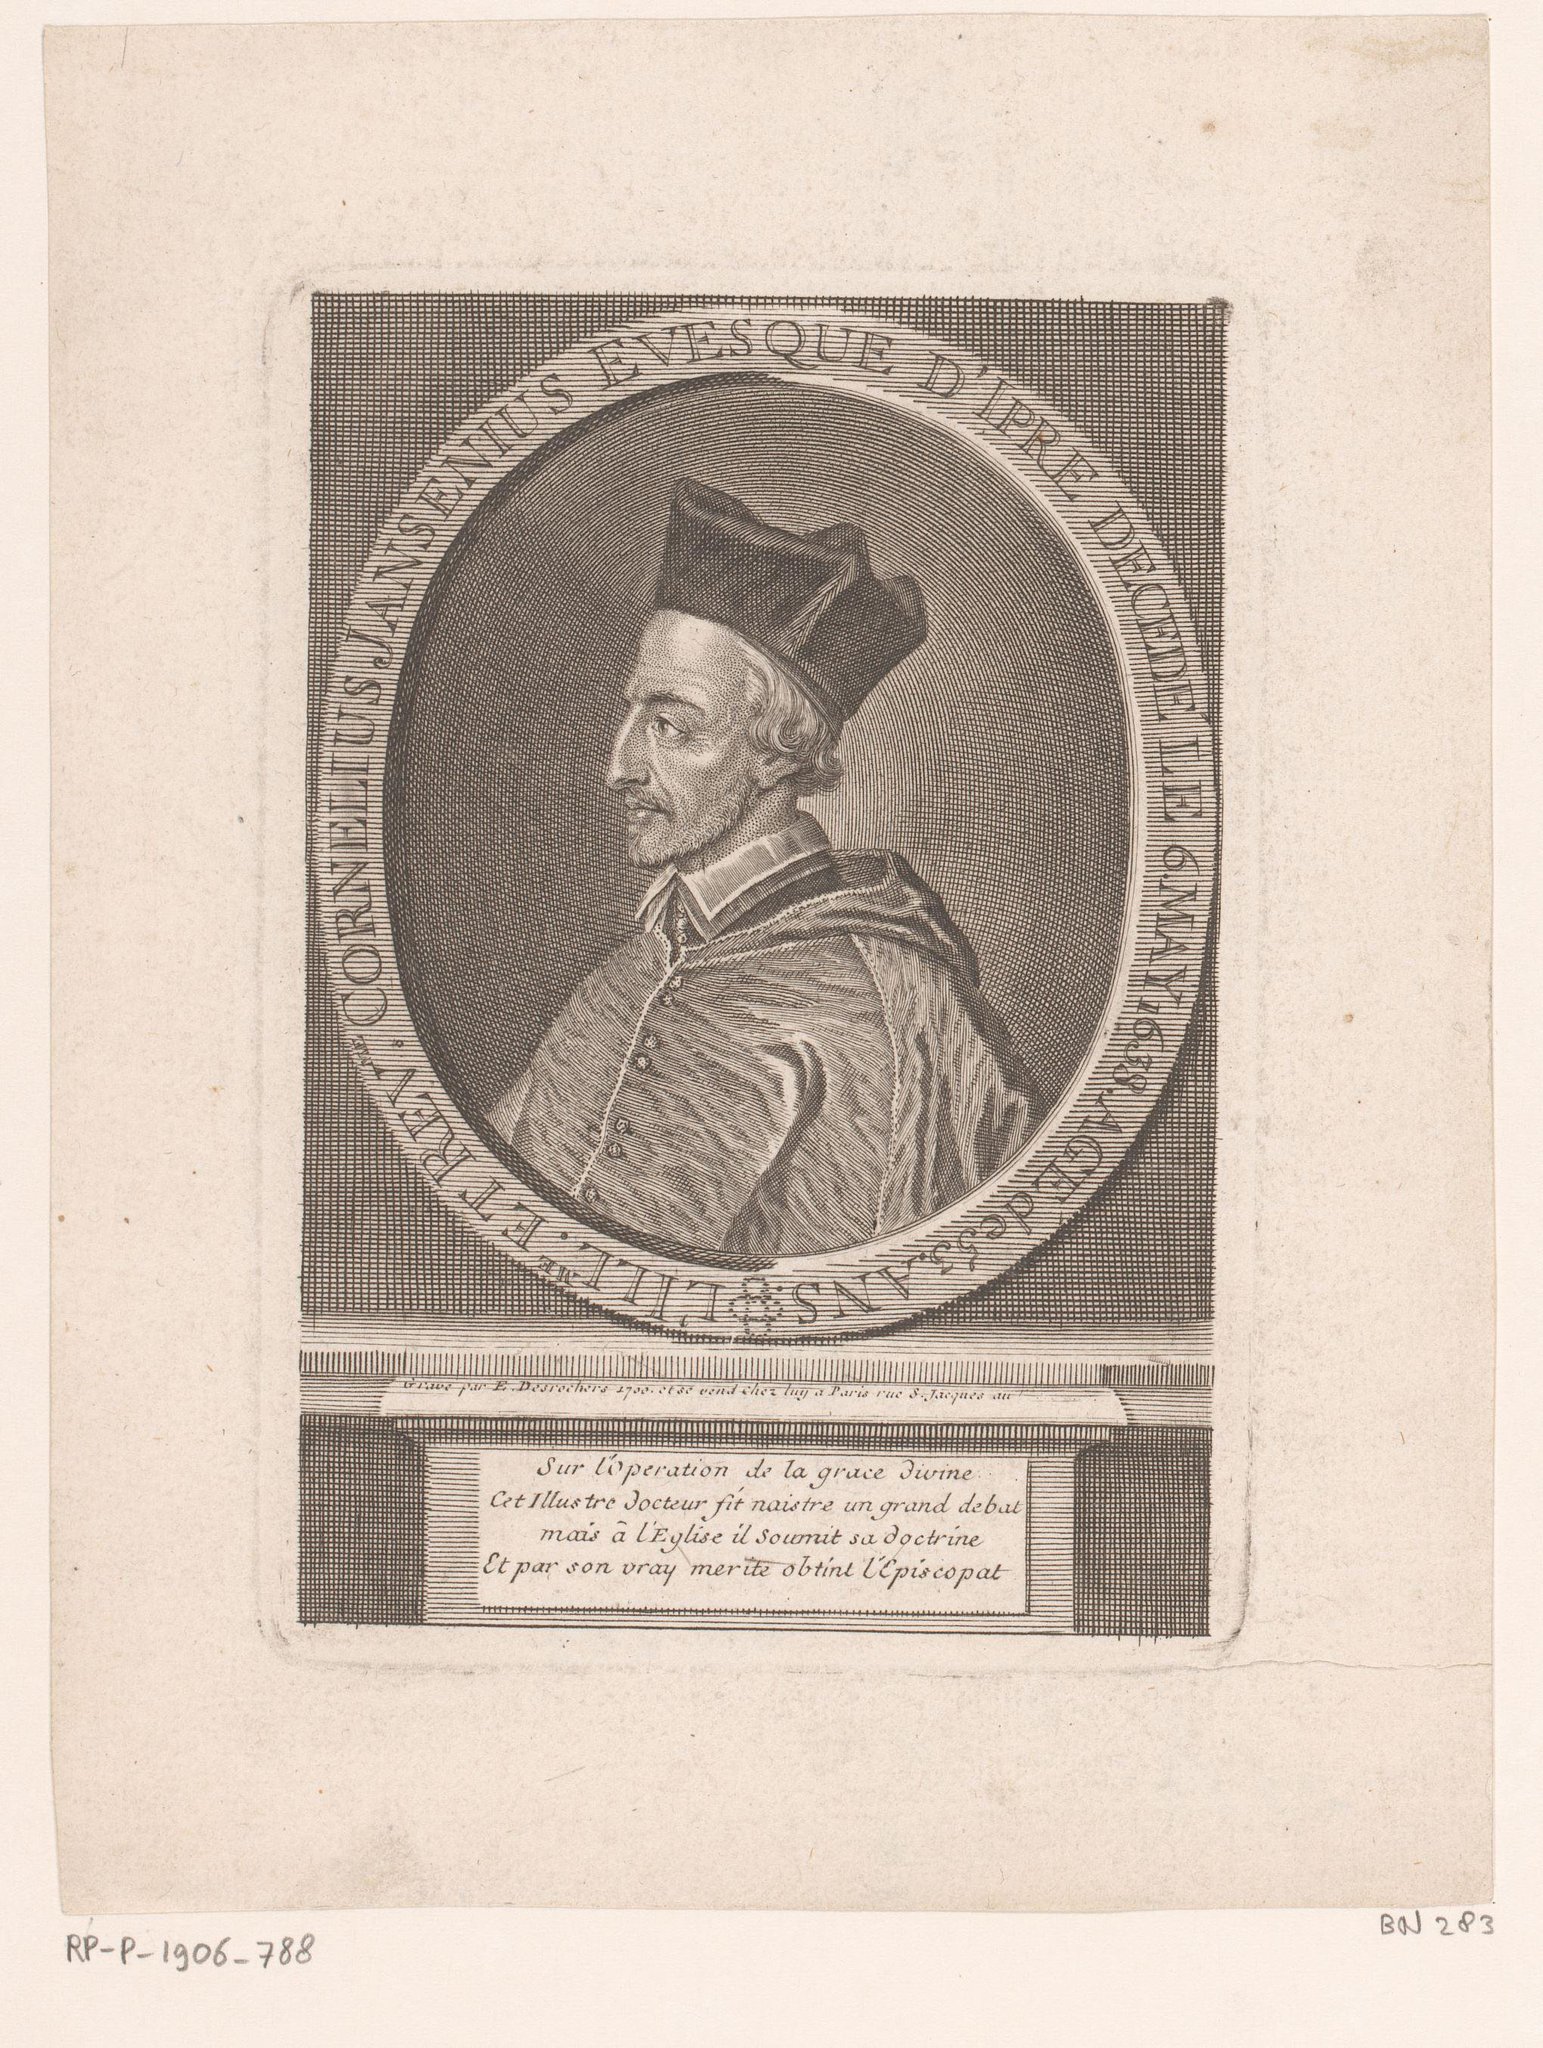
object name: print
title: Portret van Cornelius Jansenius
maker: étienne desrochers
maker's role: print maker, publisher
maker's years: 1668-1741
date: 1700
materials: paper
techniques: engraving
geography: paris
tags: louvain, priest, archbishop, bishop, etc. (roman catholic), theologian, historical persons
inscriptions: collector's mark: Lugt 2228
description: Behoort waarschijnlijk tot een serie portretten, grotendeels door Etienne Desrochers, getiteld: 'Recueil de portraits de personnes qui se sont distinguées tant dans les Armes que dans Belles-Lettres et les Arts, comme aussi la famille royale de France et autres cours étrangères'. De serie werd initieel uitgegeven door Desrochers en aangekondigd in 'Mercure' in mei 1726, p. 985. Echter was Desrochers reeds enkele jaren eerder begonnen met het uitgeven van de serie. Na de dood van Desrochers werd de serie voortgezet door Gilles Edme Petit. Een latere staat werd uitgegeven door Jean François Daumont in Parijs.